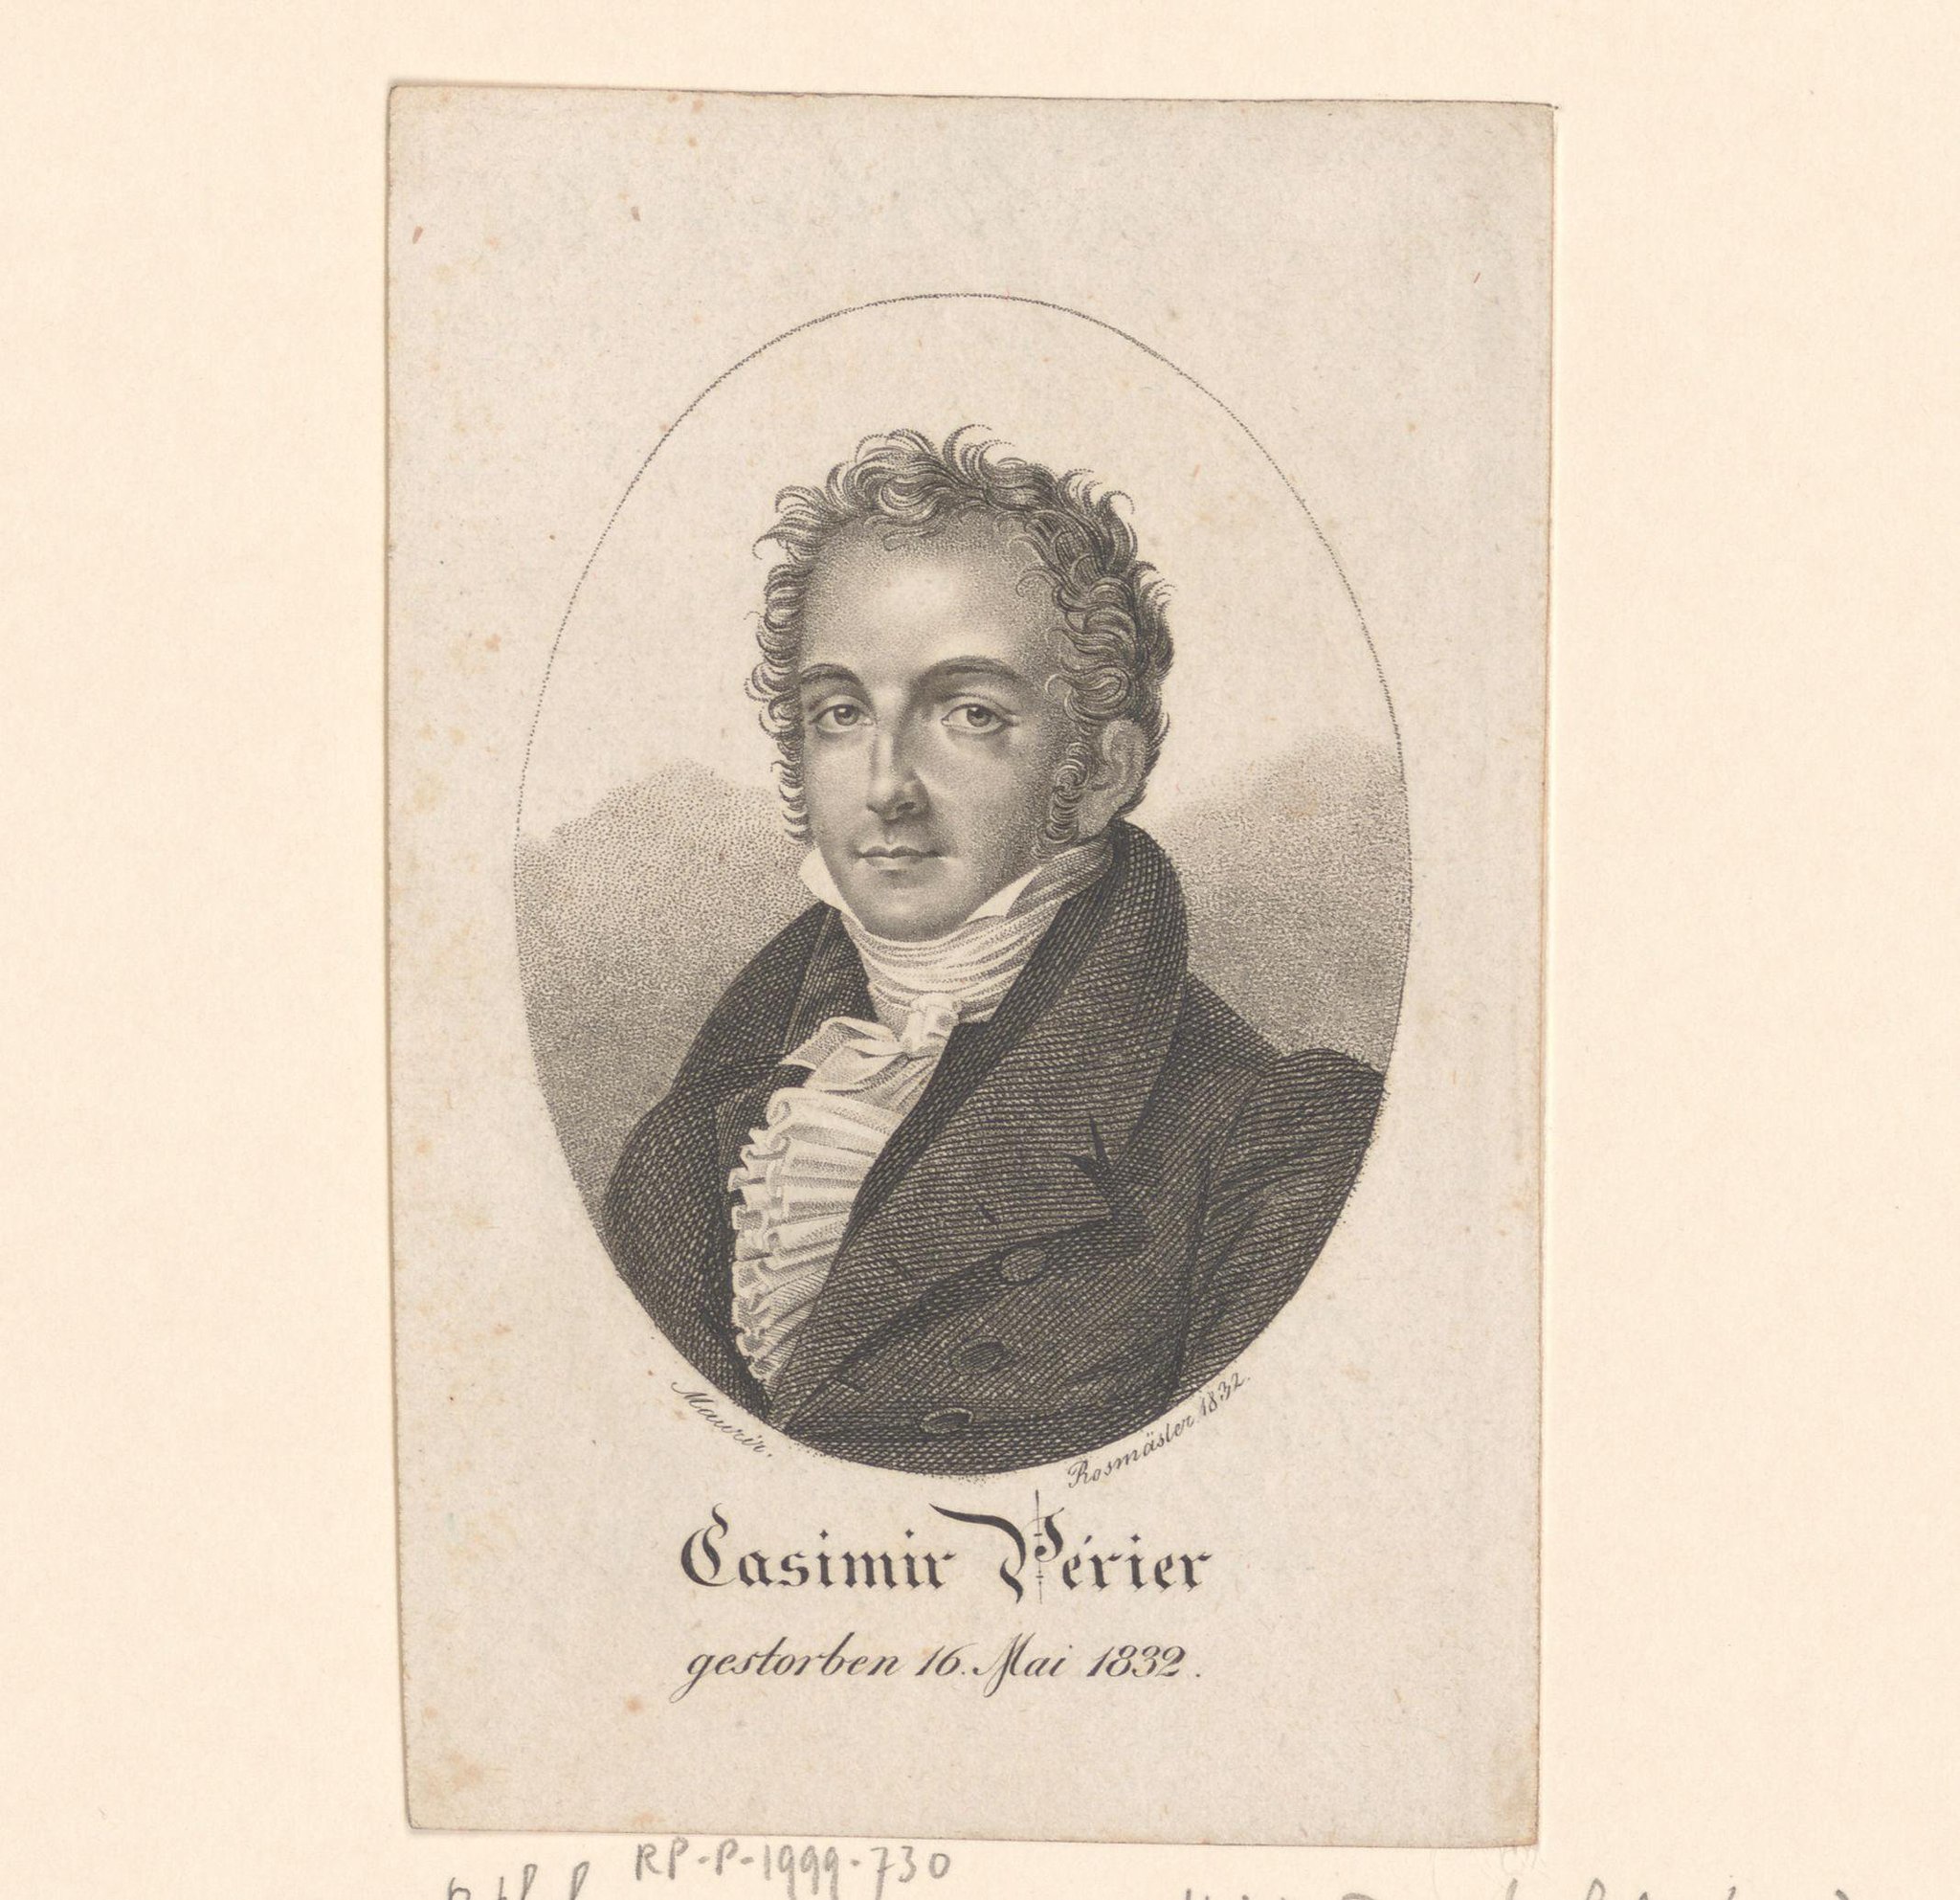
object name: print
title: Portret van Casimir-Pierre Périer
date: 1832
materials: paper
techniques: engraving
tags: paris, politician, adult man, historical persons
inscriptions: inscription: ‘Portr. 60548/ Périer Cas/ LB XXIV 442914’, collector's mark: Lugt 2228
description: Portret van Casimir Périer, Homme d'Etat, gemaakt in zijn sterfjaar 1832. Buste naar links, in ovaal.